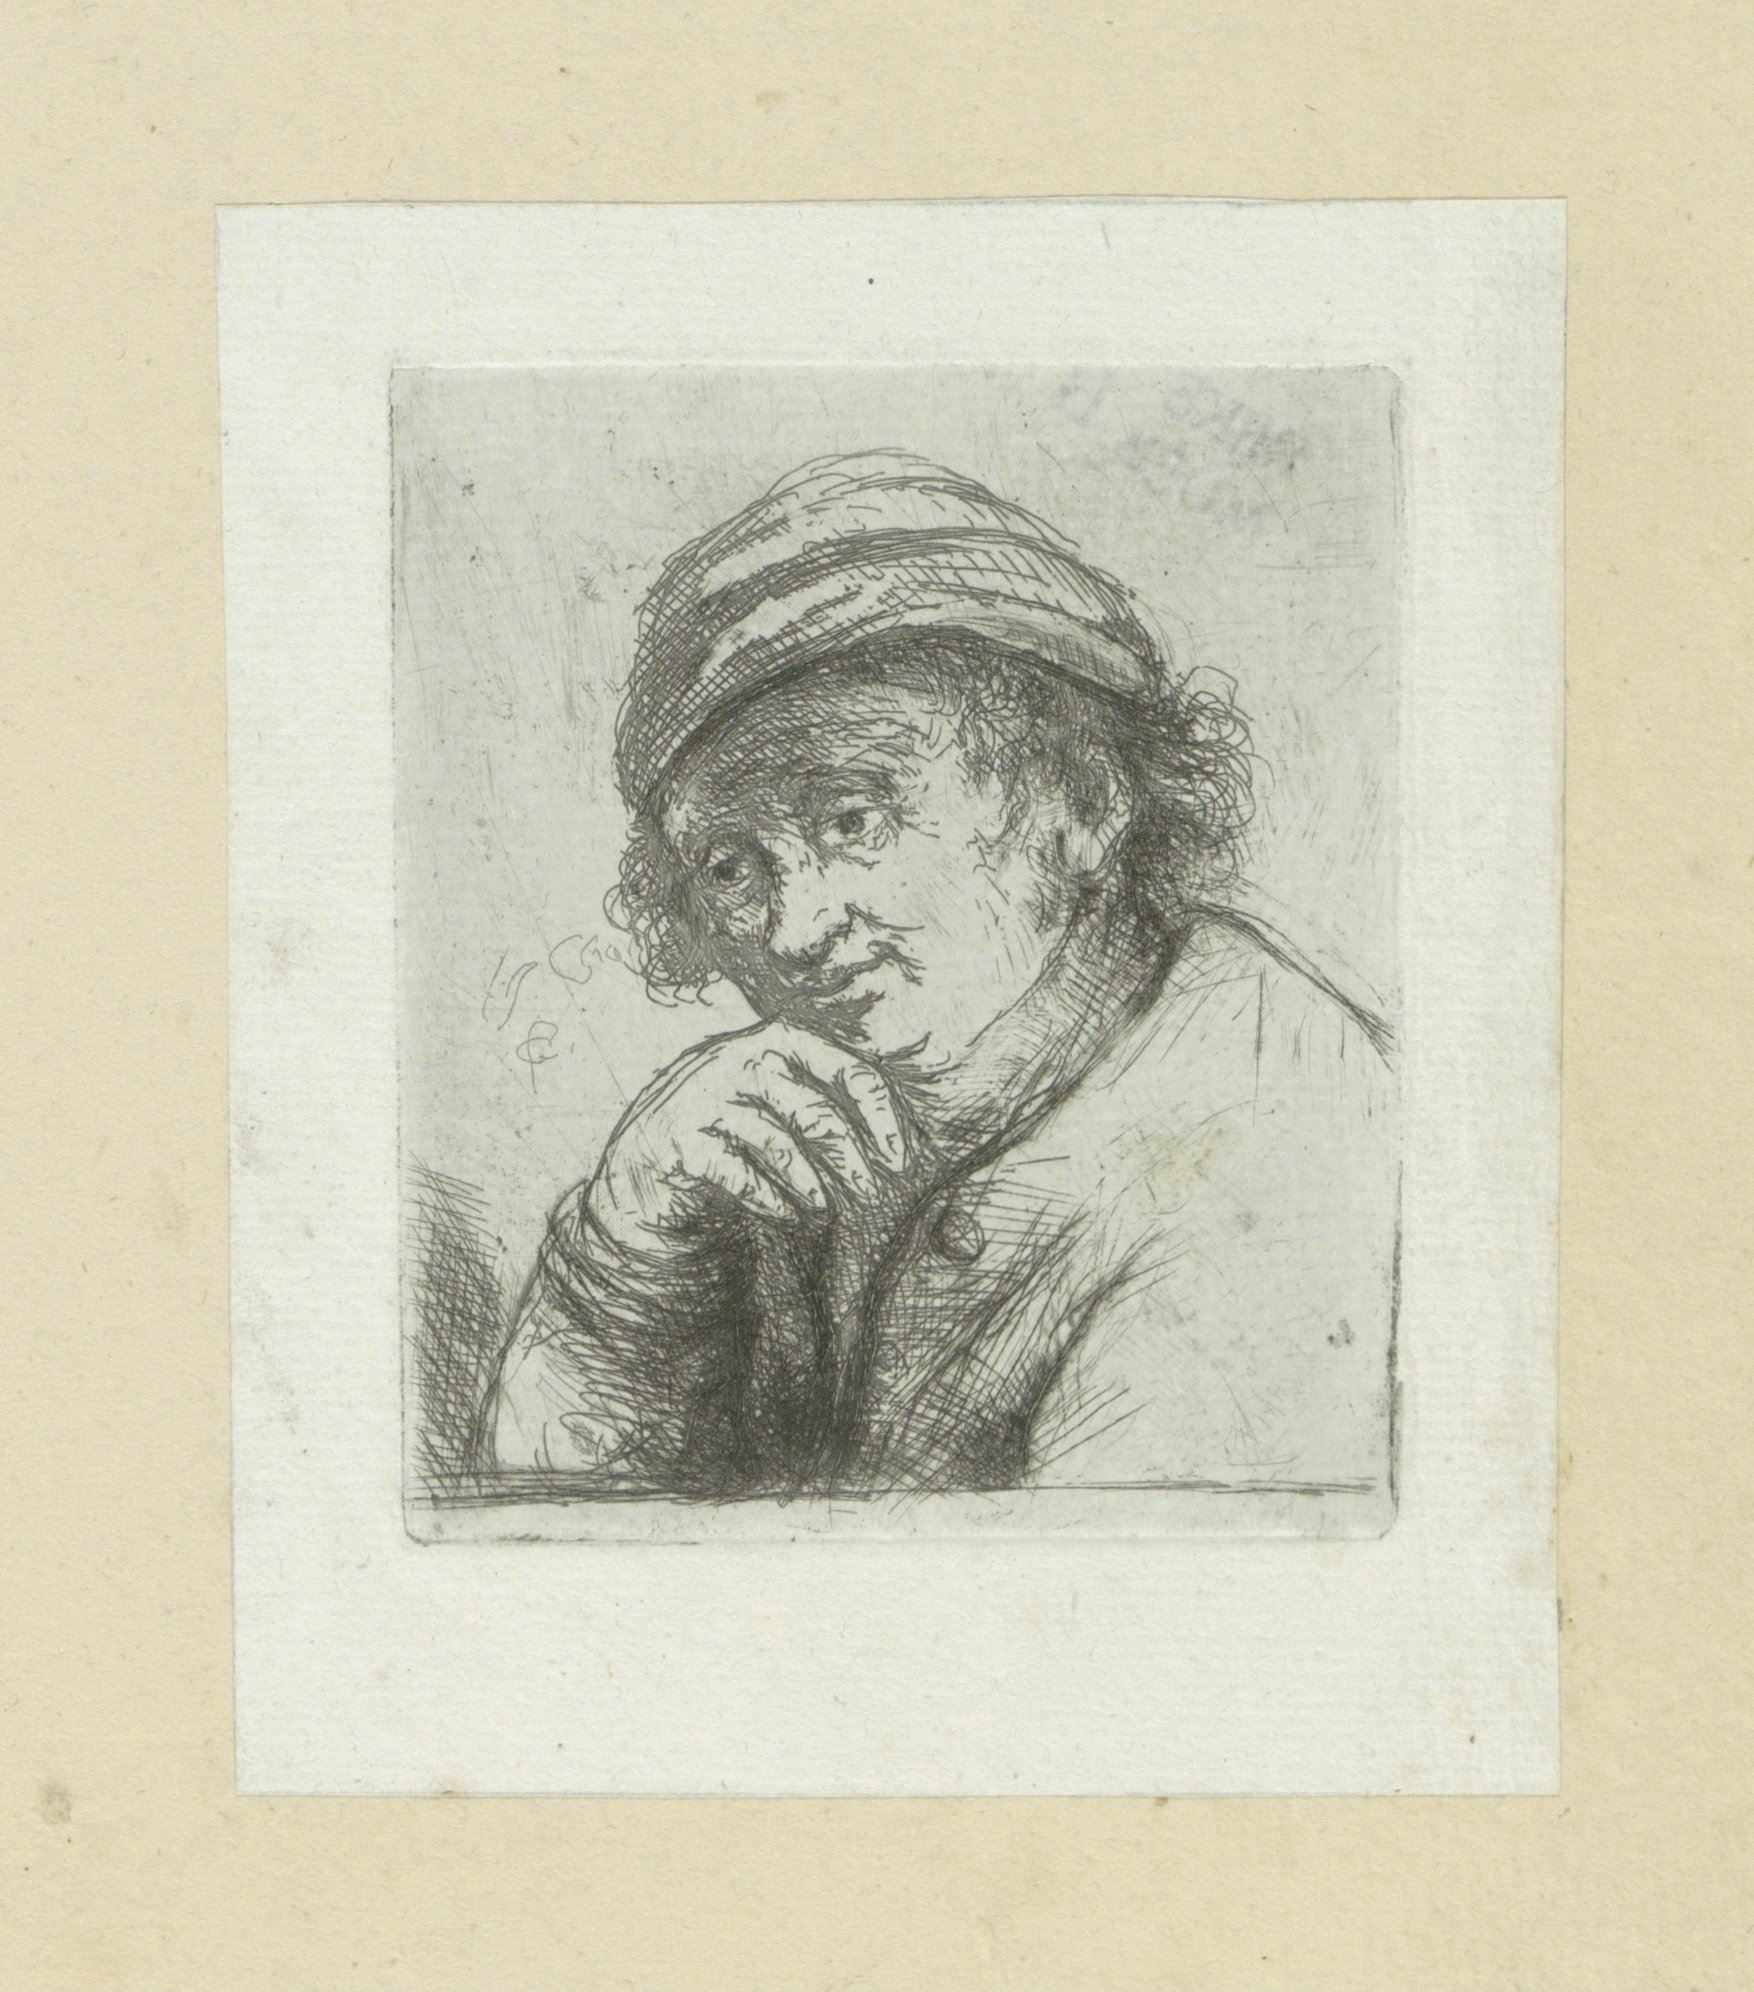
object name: album leaf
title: Man met hand onder zijn kin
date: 1802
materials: paper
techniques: drypoint, etching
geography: london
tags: morphology of human expression (+ adult male (human being))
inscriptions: collector's mark: ‘B’, collector's mark: ‘RIJKS / MUSM’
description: Volwassen man met muts. Hij heeft zijn hand onder zijn kin. De prent maakt deel uit van een album.